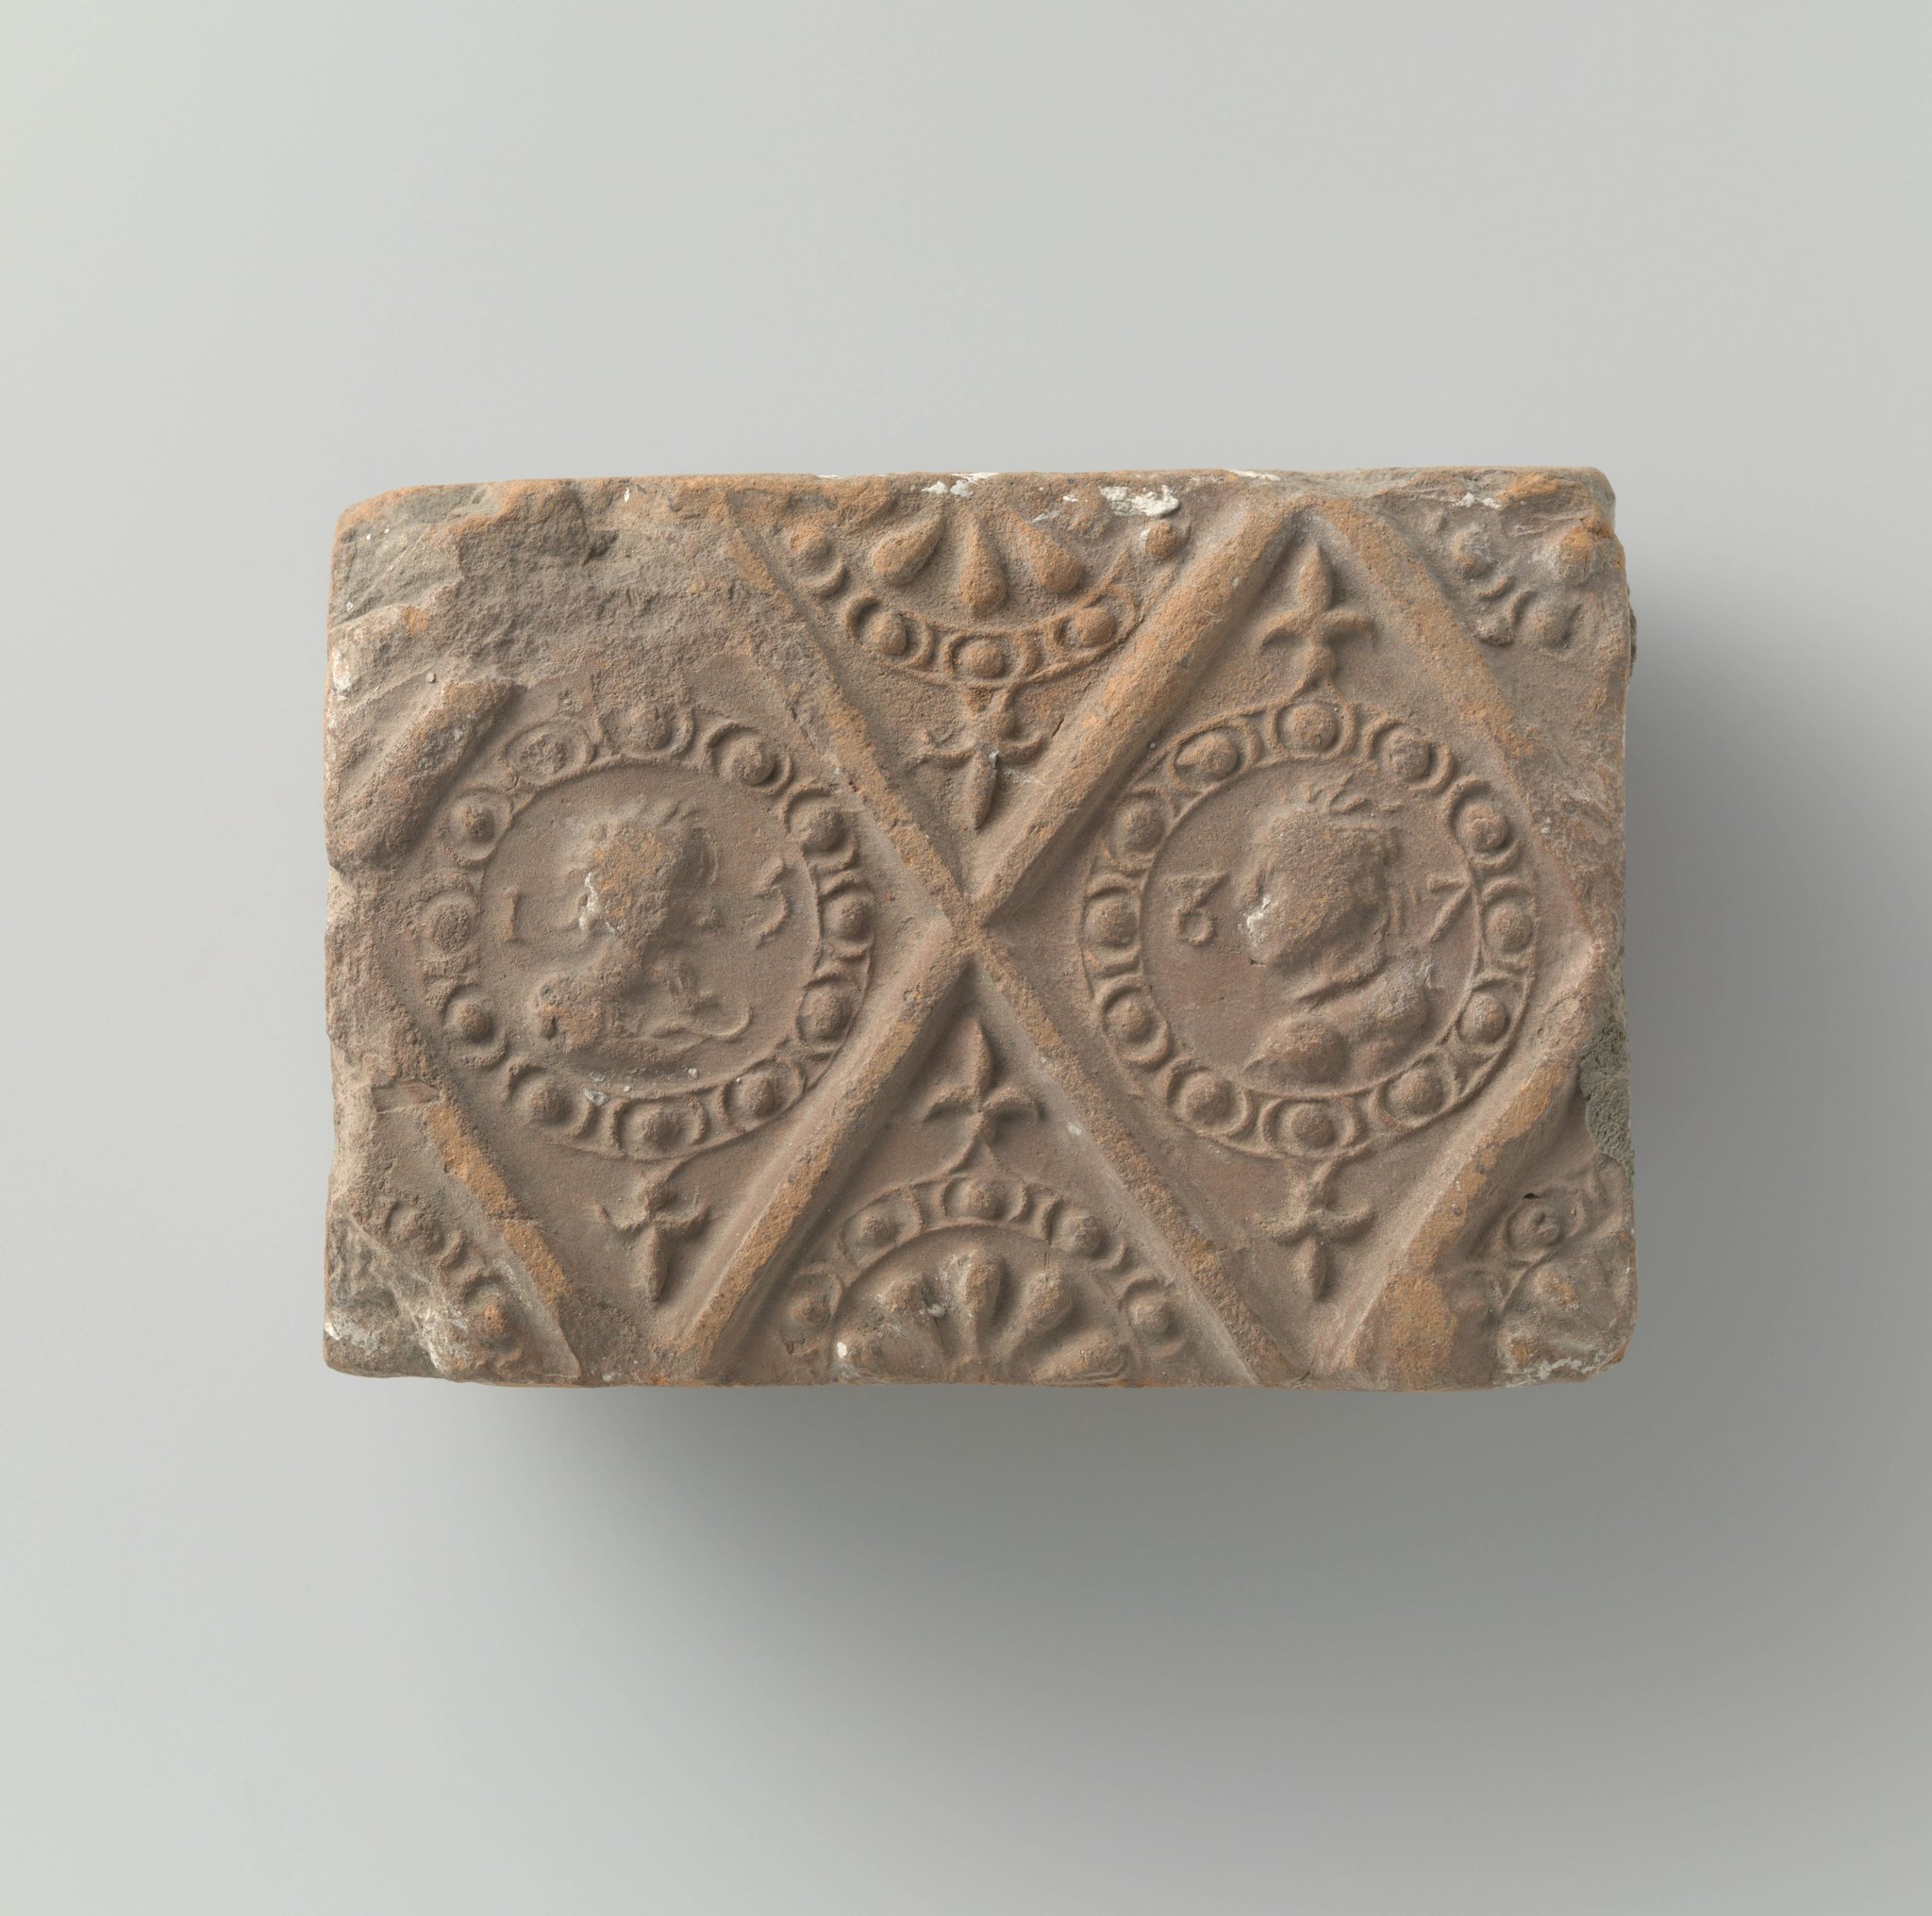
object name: architectural element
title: Haardsteen van gebakken aarde met ruitvormige verdeling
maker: Anonymous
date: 1587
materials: earthenware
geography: southern netherlands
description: Haardsteen van gebakken aarde met ruitvormige verdeling. Met het jaartal 1587. In twee stukken.